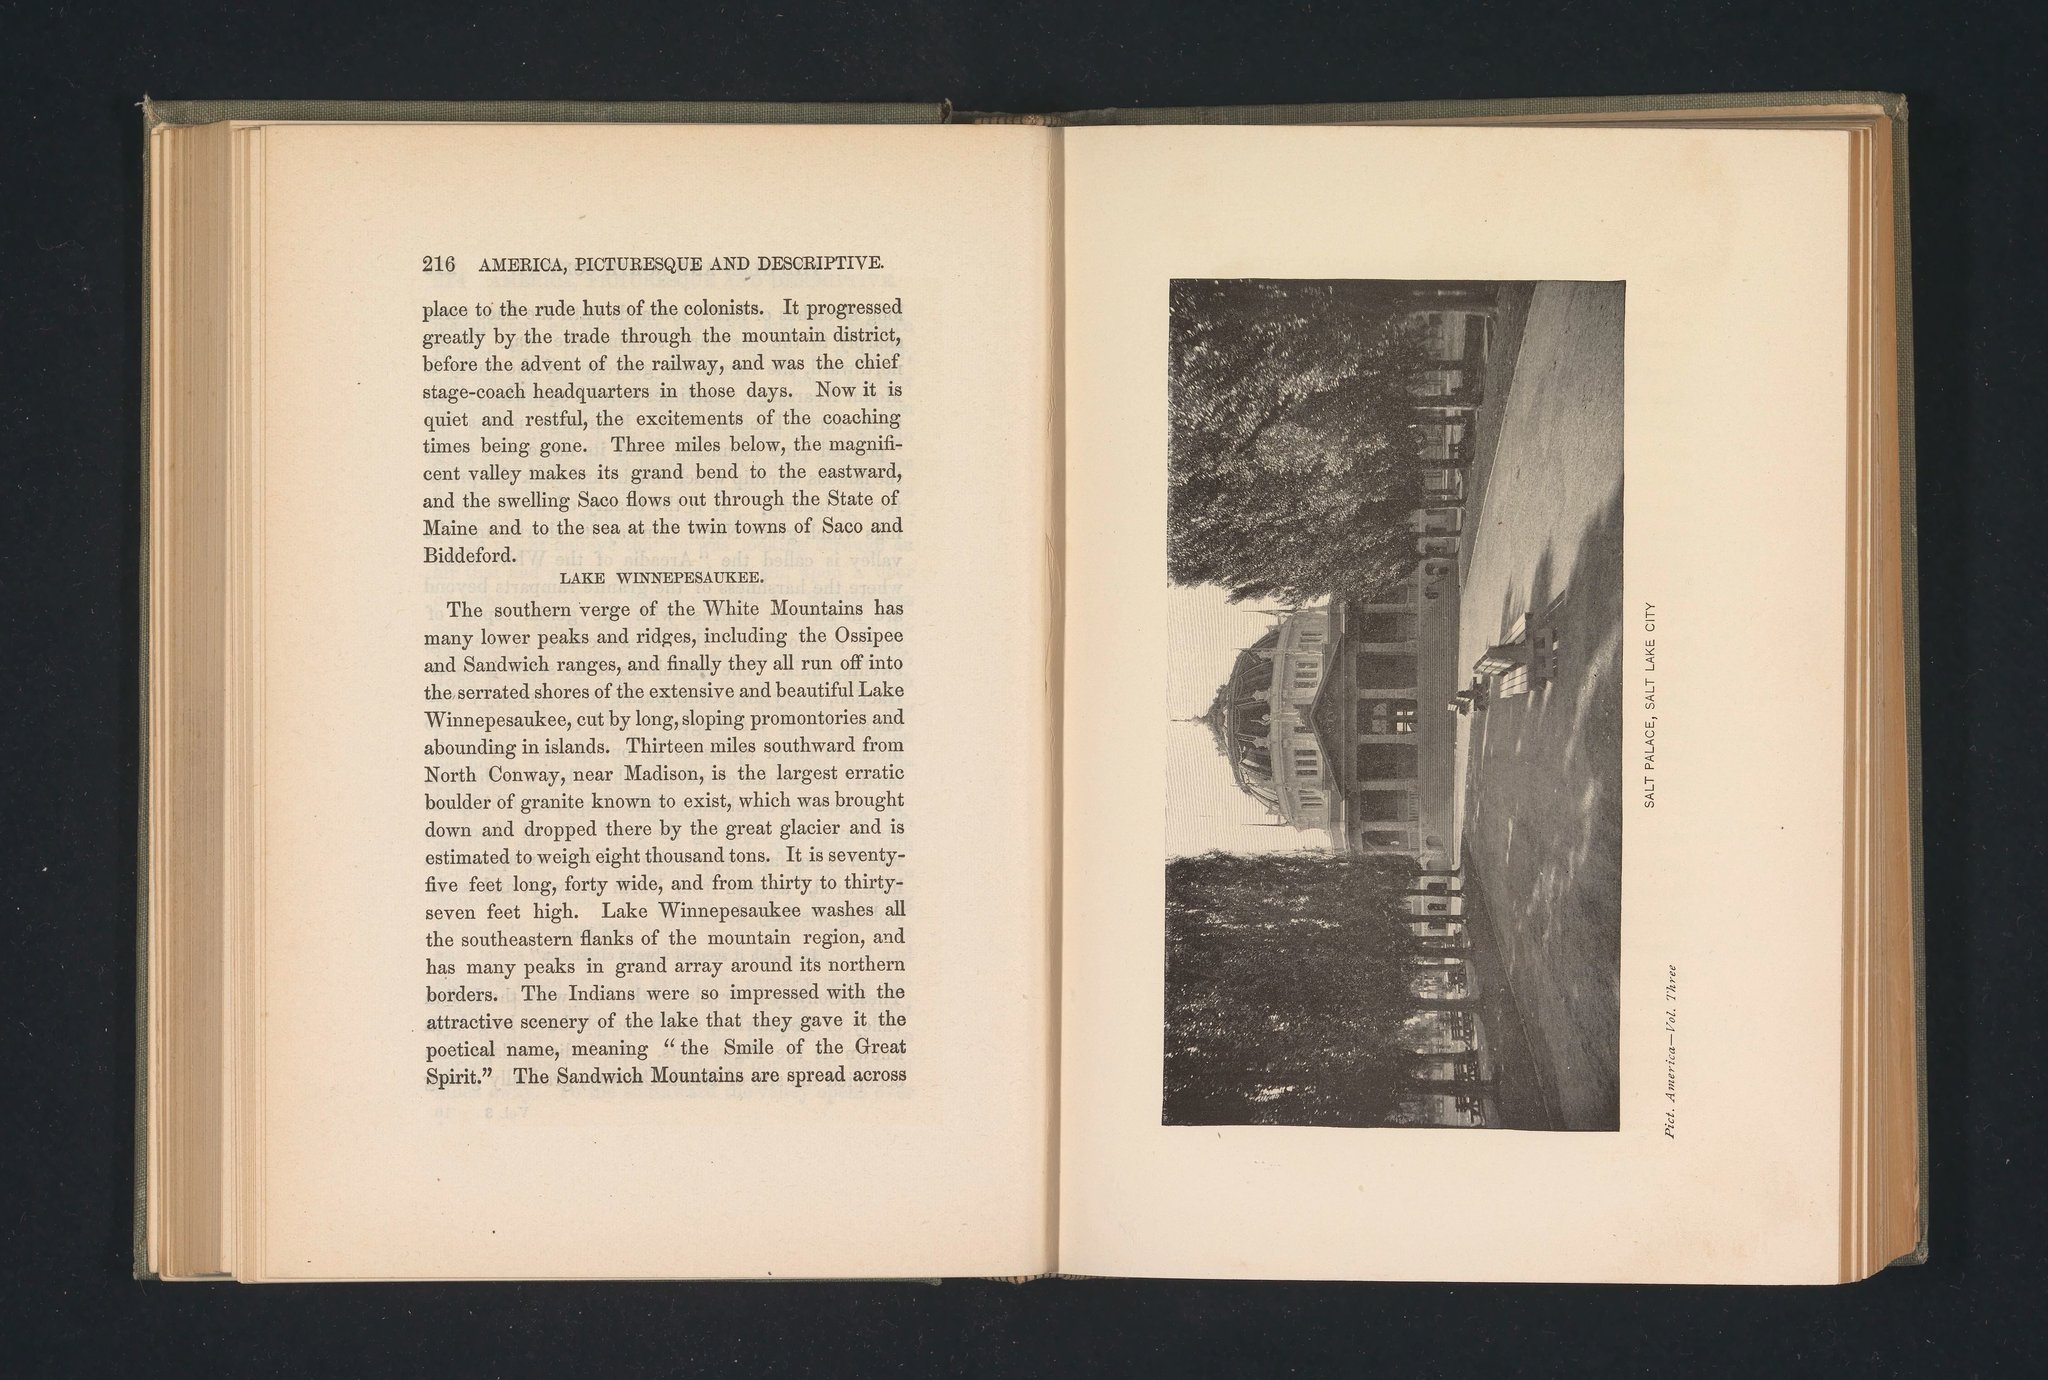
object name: page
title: Salt Palace, Salt Lake City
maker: Anonymous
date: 1890-1900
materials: paper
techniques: autotype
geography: salt lake city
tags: night-club, dance-hall